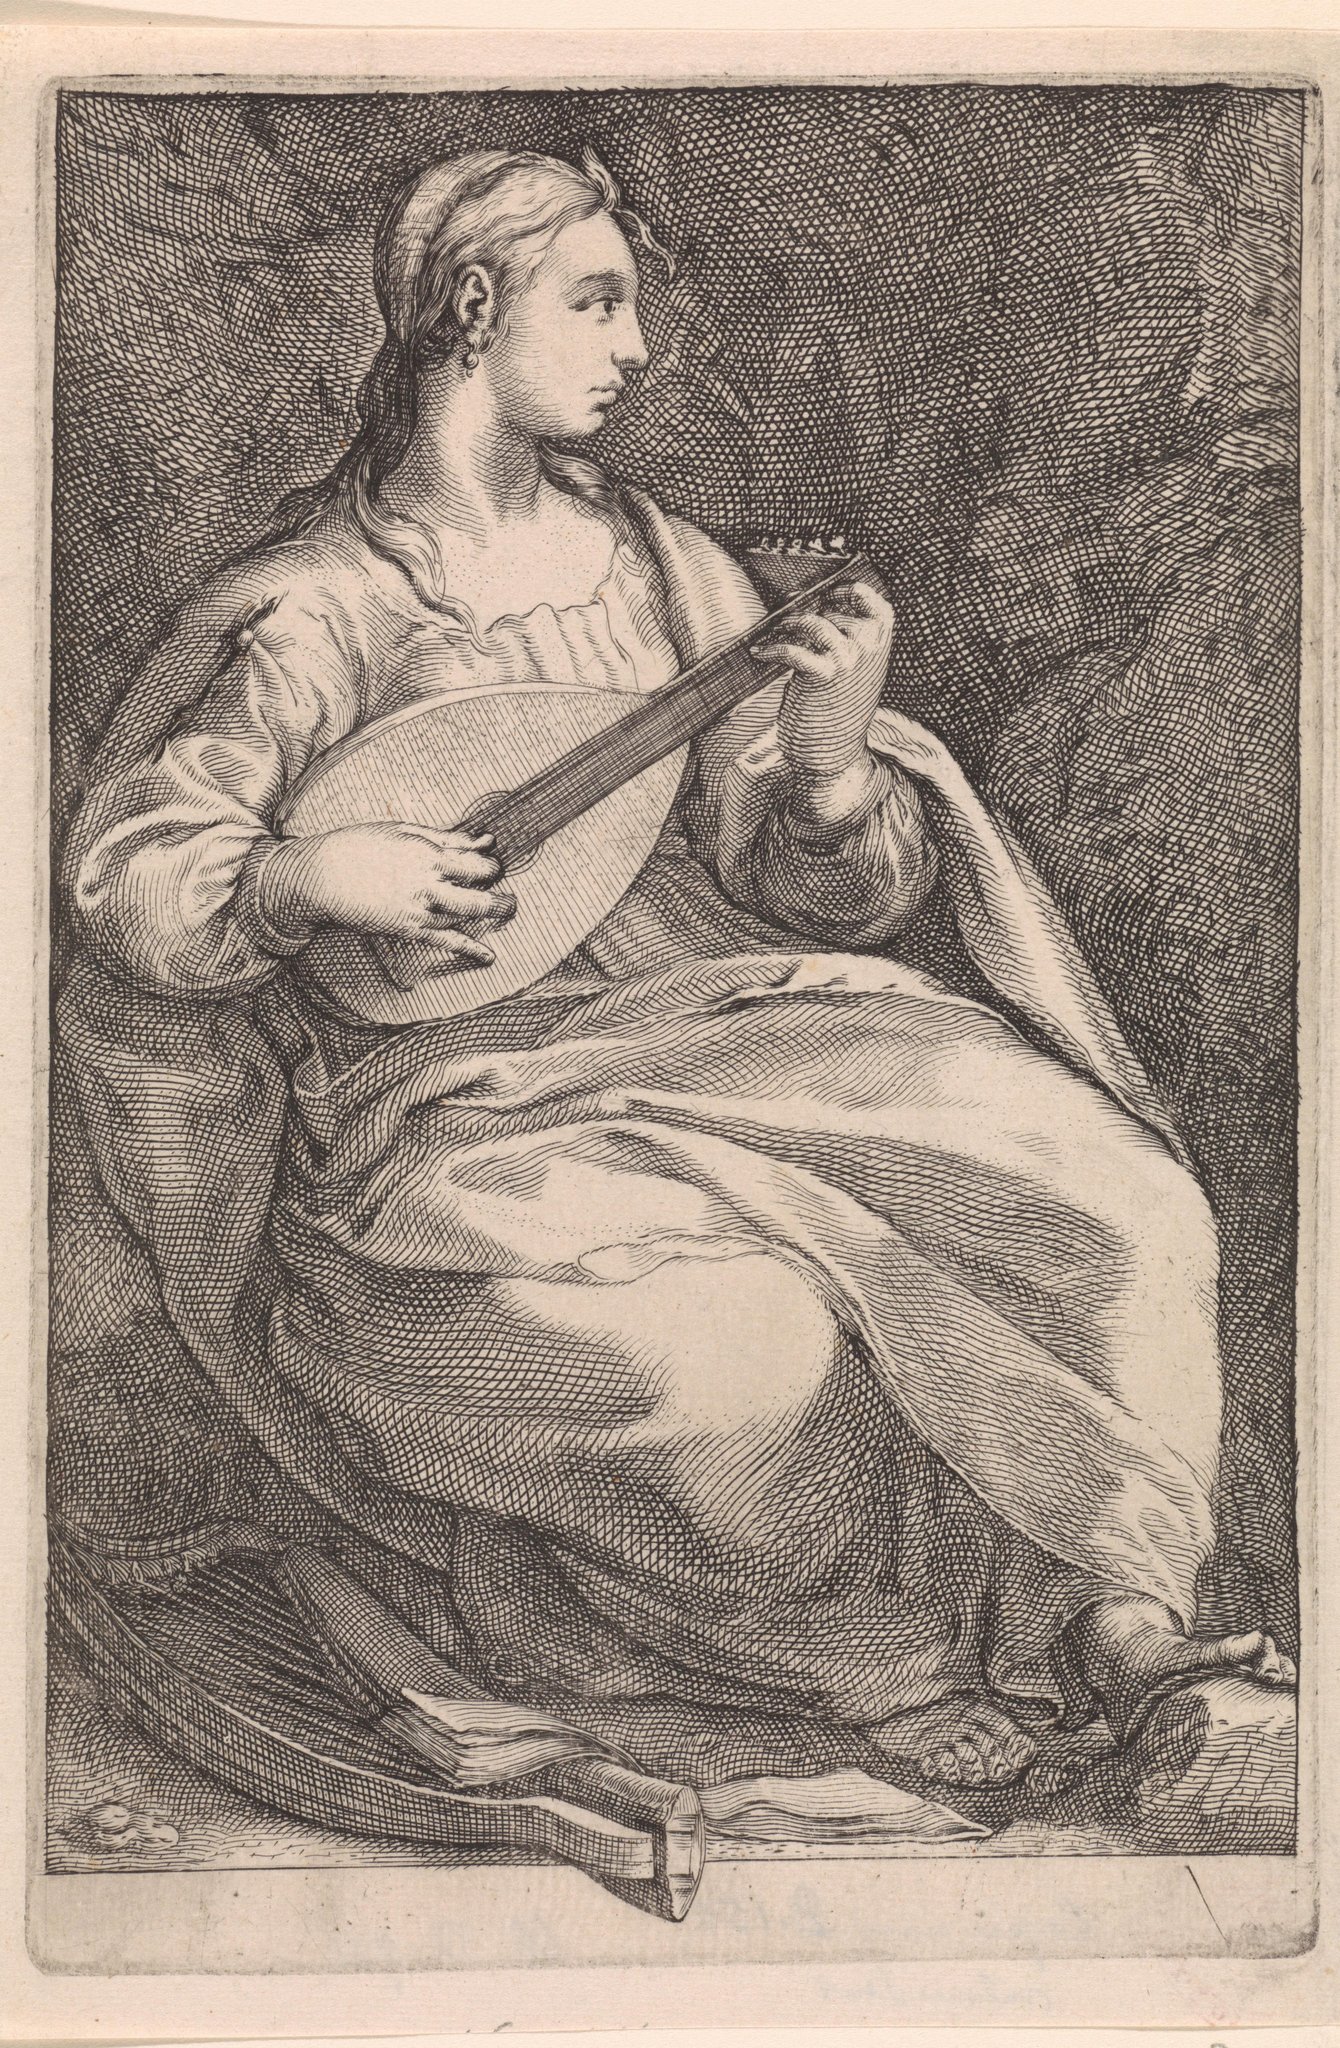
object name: print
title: Terpsichore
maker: Anonymous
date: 1592-1667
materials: paper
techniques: drypoint, engraving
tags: terpsichore (one of the muses); 'terpsicore' (ripa)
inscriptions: collector's mark: Lugt 240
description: De zittende Terpsichore, de muze van de zang en dans, bespeelt de luit. Links aan haar voeten liggen een lier en een boek.